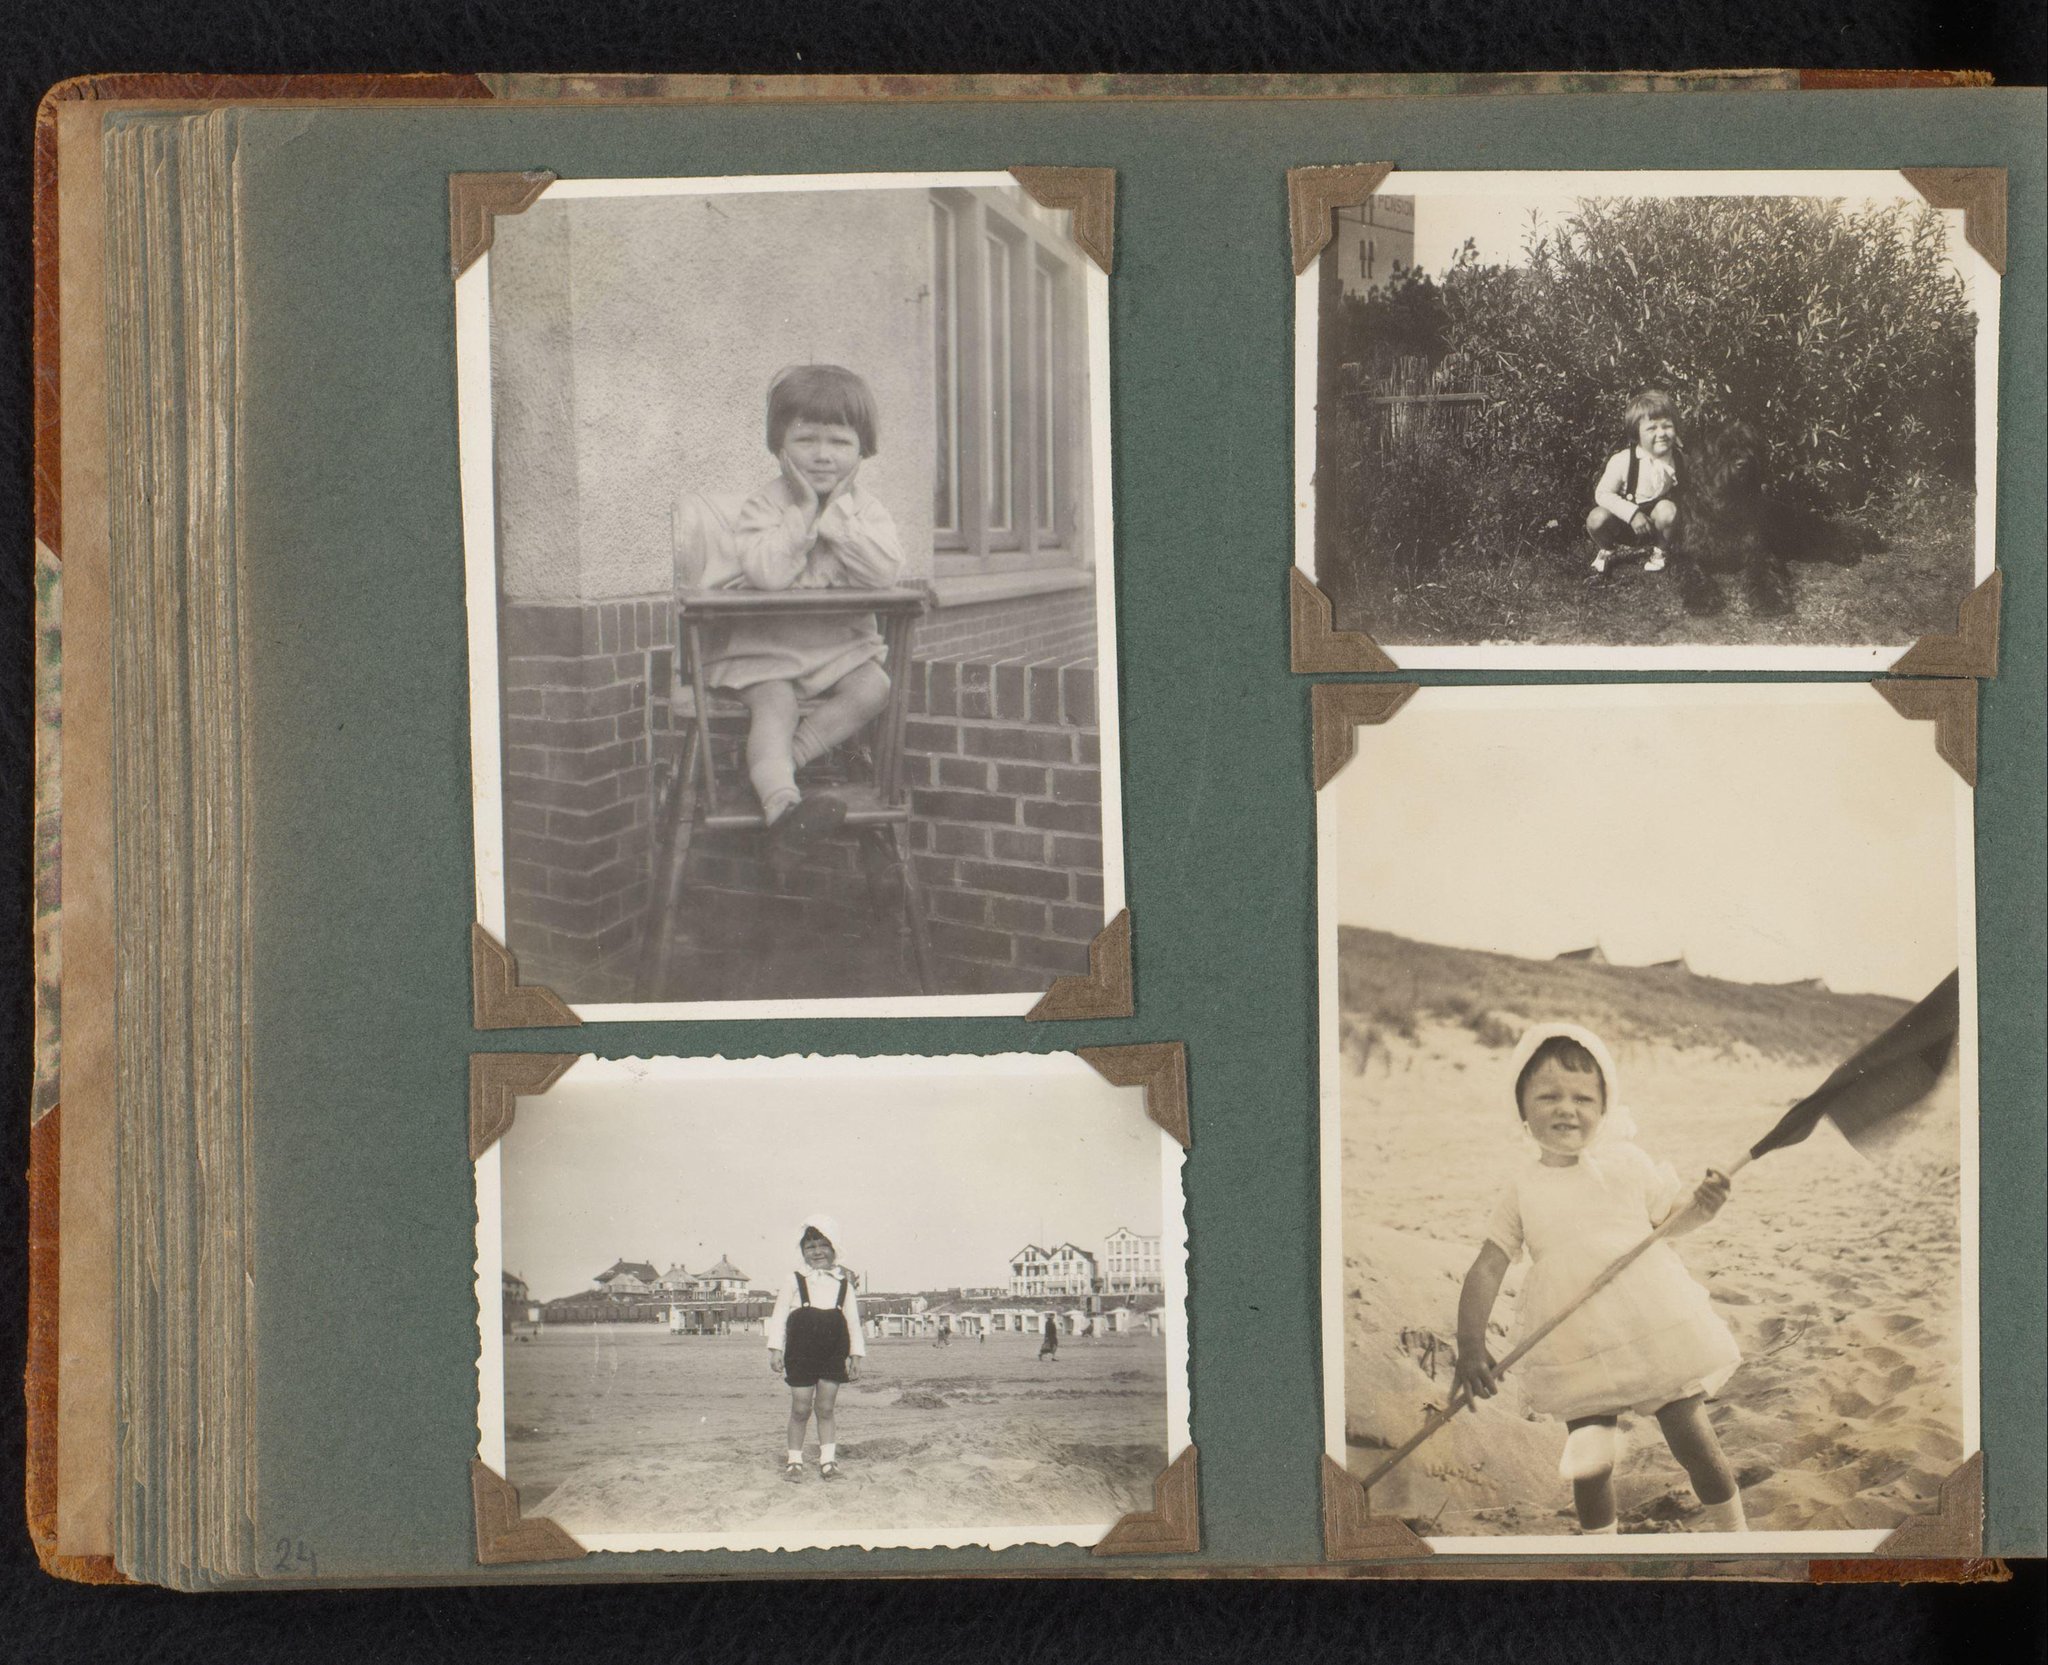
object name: photograph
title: Vier foto's van kinderen van familie Onnen-Van den Berg tijdens een vakantie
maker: Anonymous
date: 1920-1930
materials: paper, cardboard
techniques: gelatin silver print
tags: beach (as place of recreation), child, historical persons, family life, dog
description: Deze foto's maken deel uit van een album.